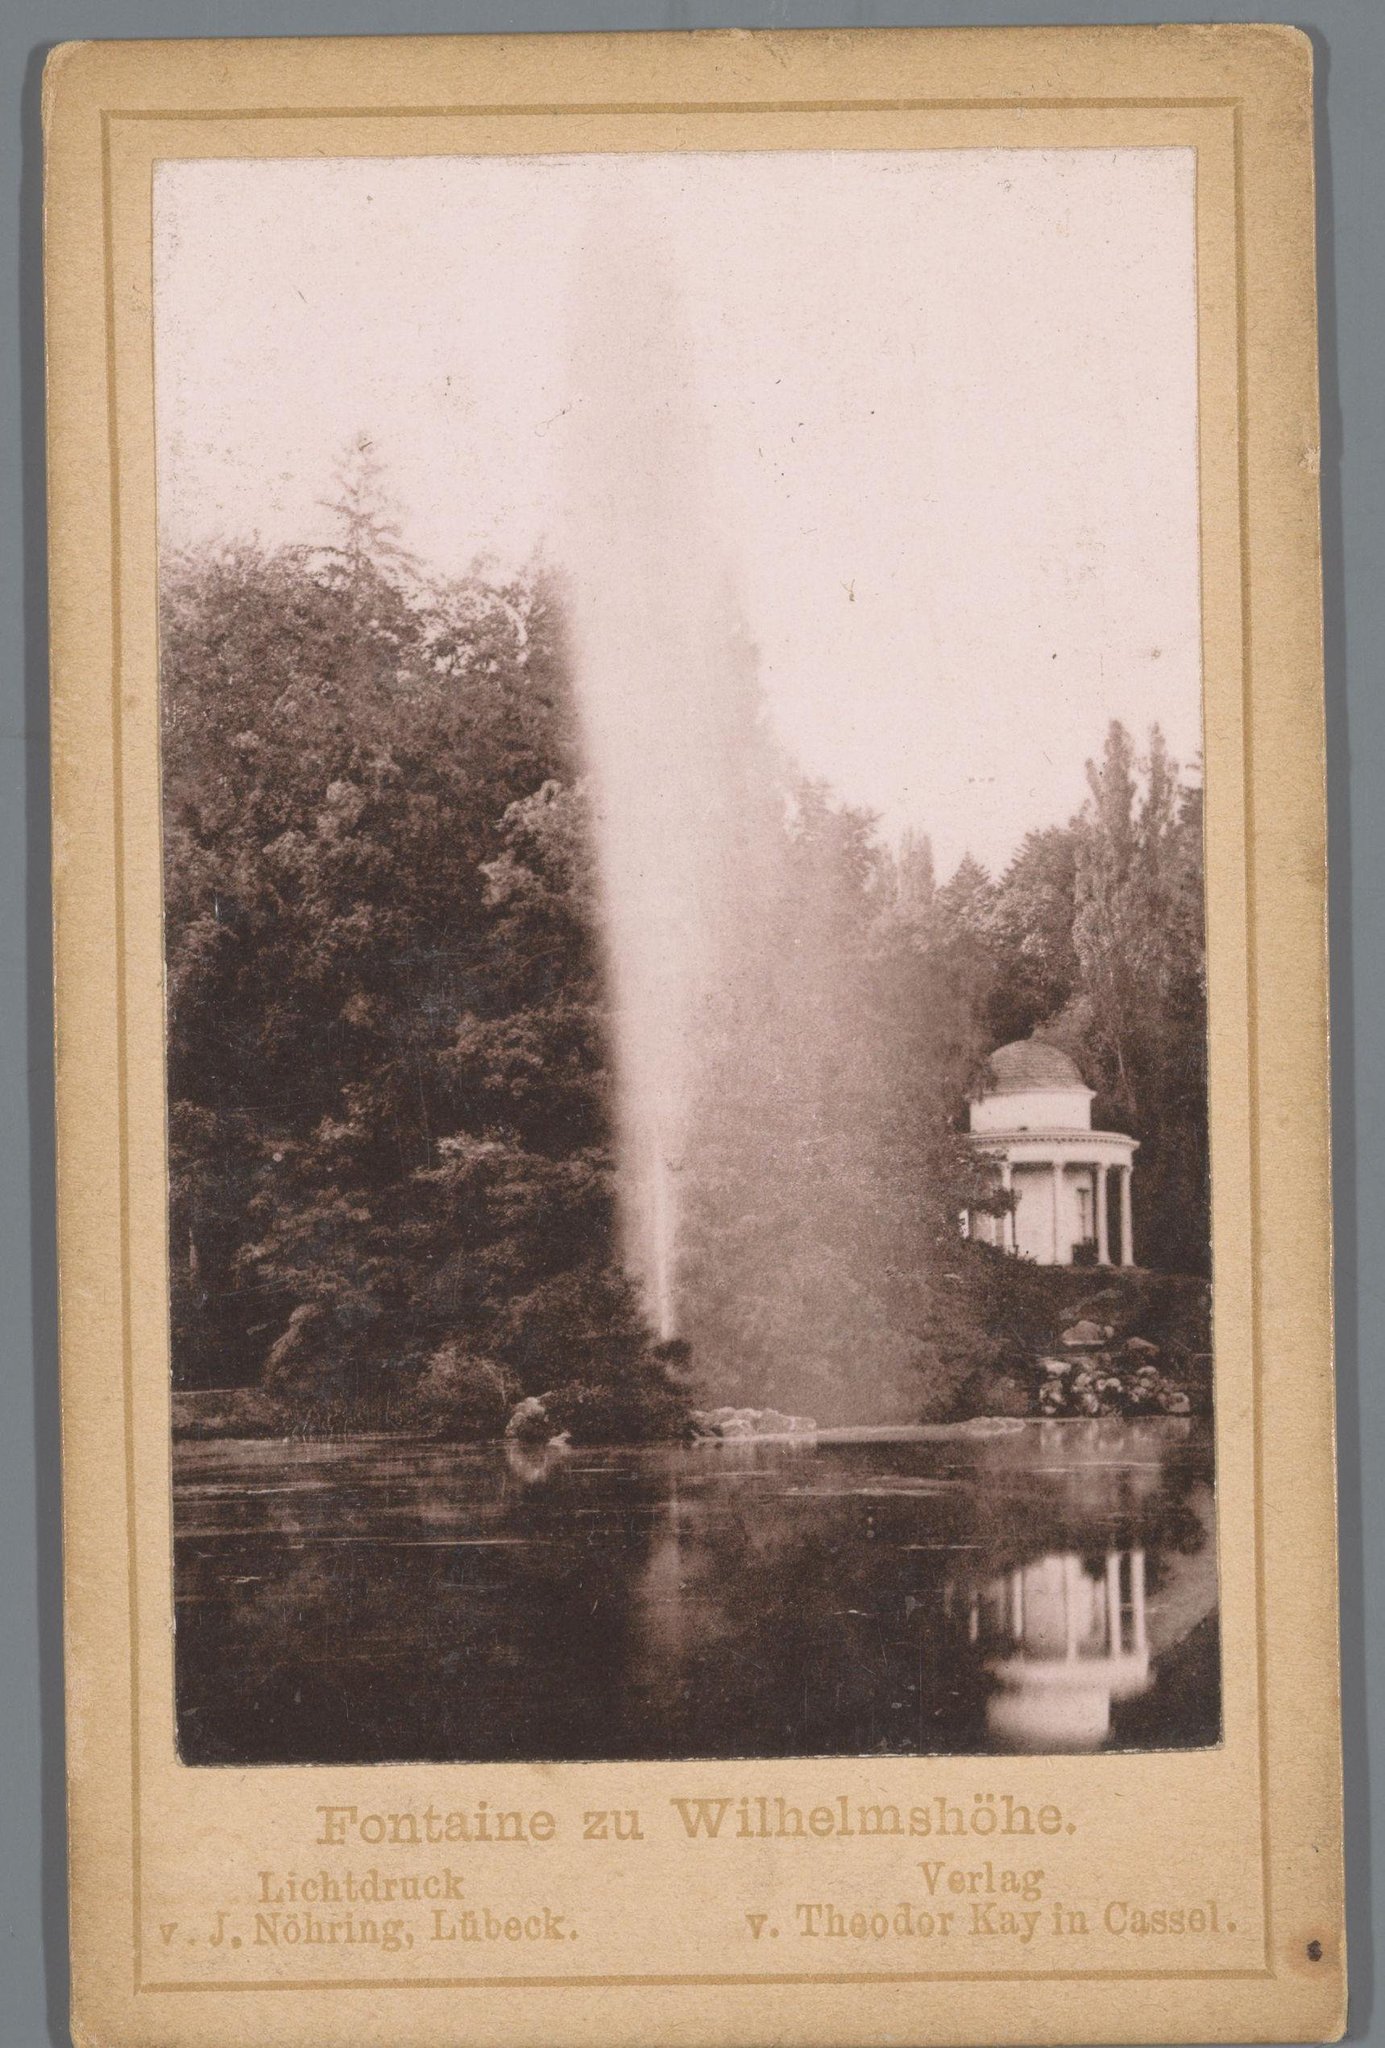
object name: carte de visite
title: Fontaine Zu Wilhelmshöhe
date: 1876-1904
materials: cardboard, paper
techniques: photograph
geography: kassel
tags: garden fountain